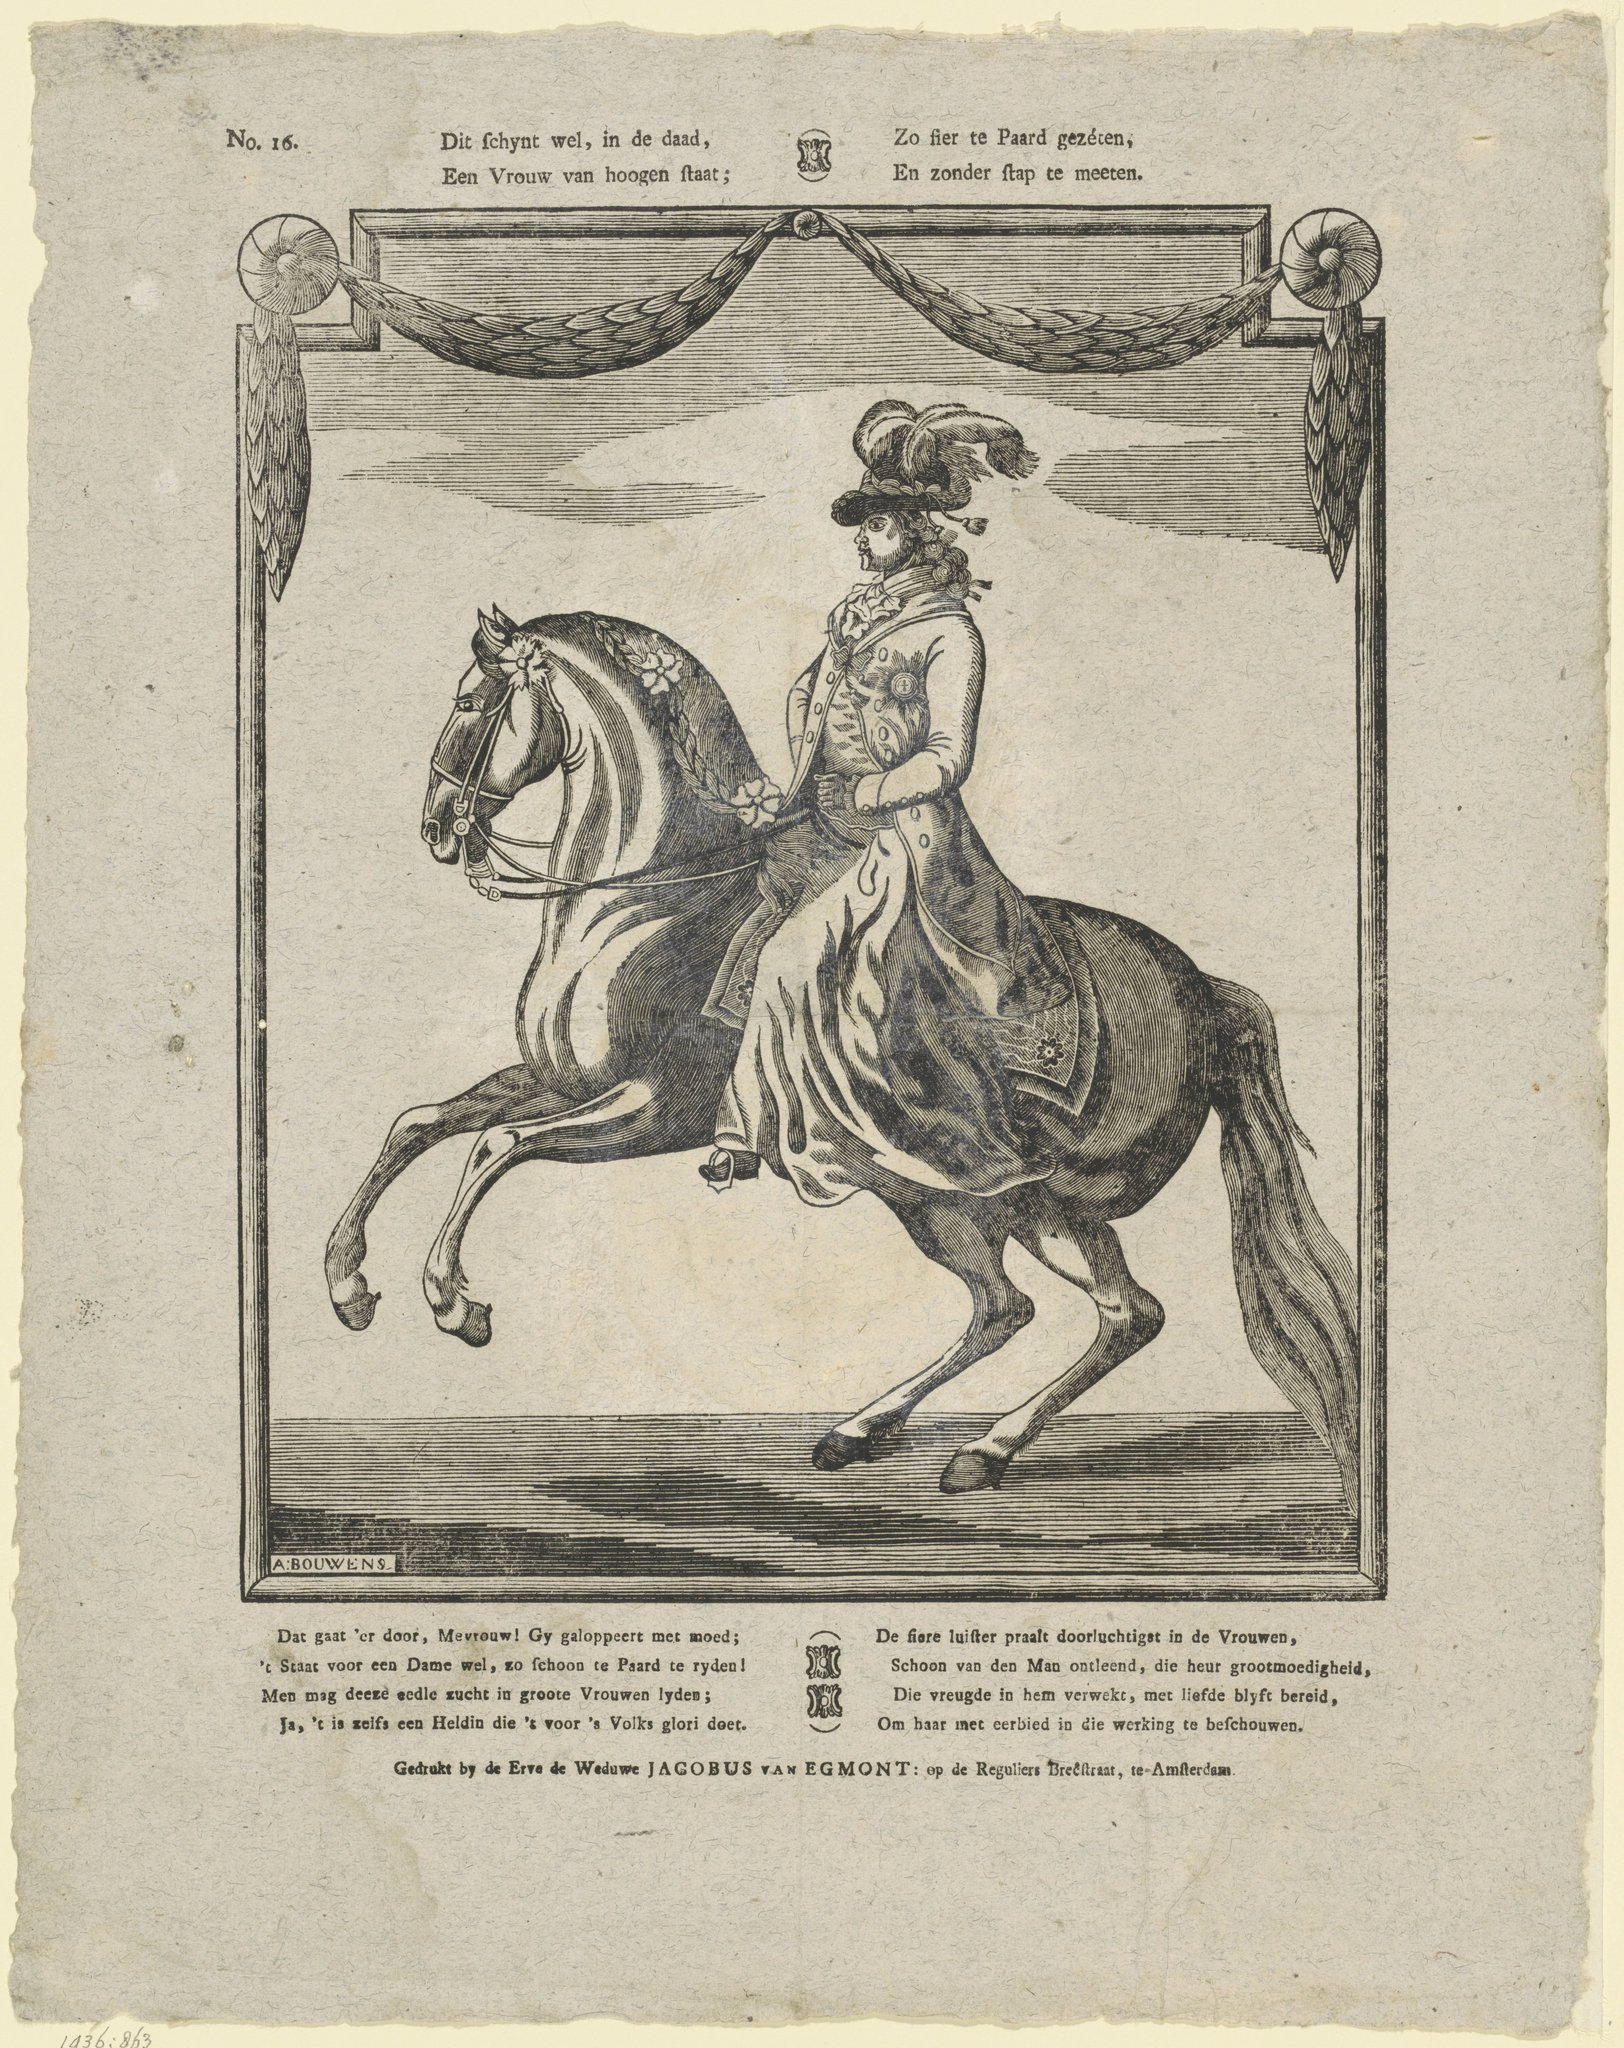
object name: print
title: Ruiterportret van Wilhelmina van Pruisen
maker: a. bouwens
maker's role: bloksnijder, houtsnijder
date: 1767-1787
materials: paper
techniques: woodcut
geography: amsterdam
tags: berlin, draughtsman, wilhelmina of prussia (princess of orange)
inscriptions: collector's mark: Lugt 2228, collector's mark: Lugt 2760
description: Ruiterportret van Wilhelmina in een geornamenteerde rechthoek. In de bovenmarge twee kolommen met elk twee regels Nederlandse tekst. In de ondermarge twee kolommen met elk vier regels Nederlandse tekst. Linksboven 'No. 16.'.